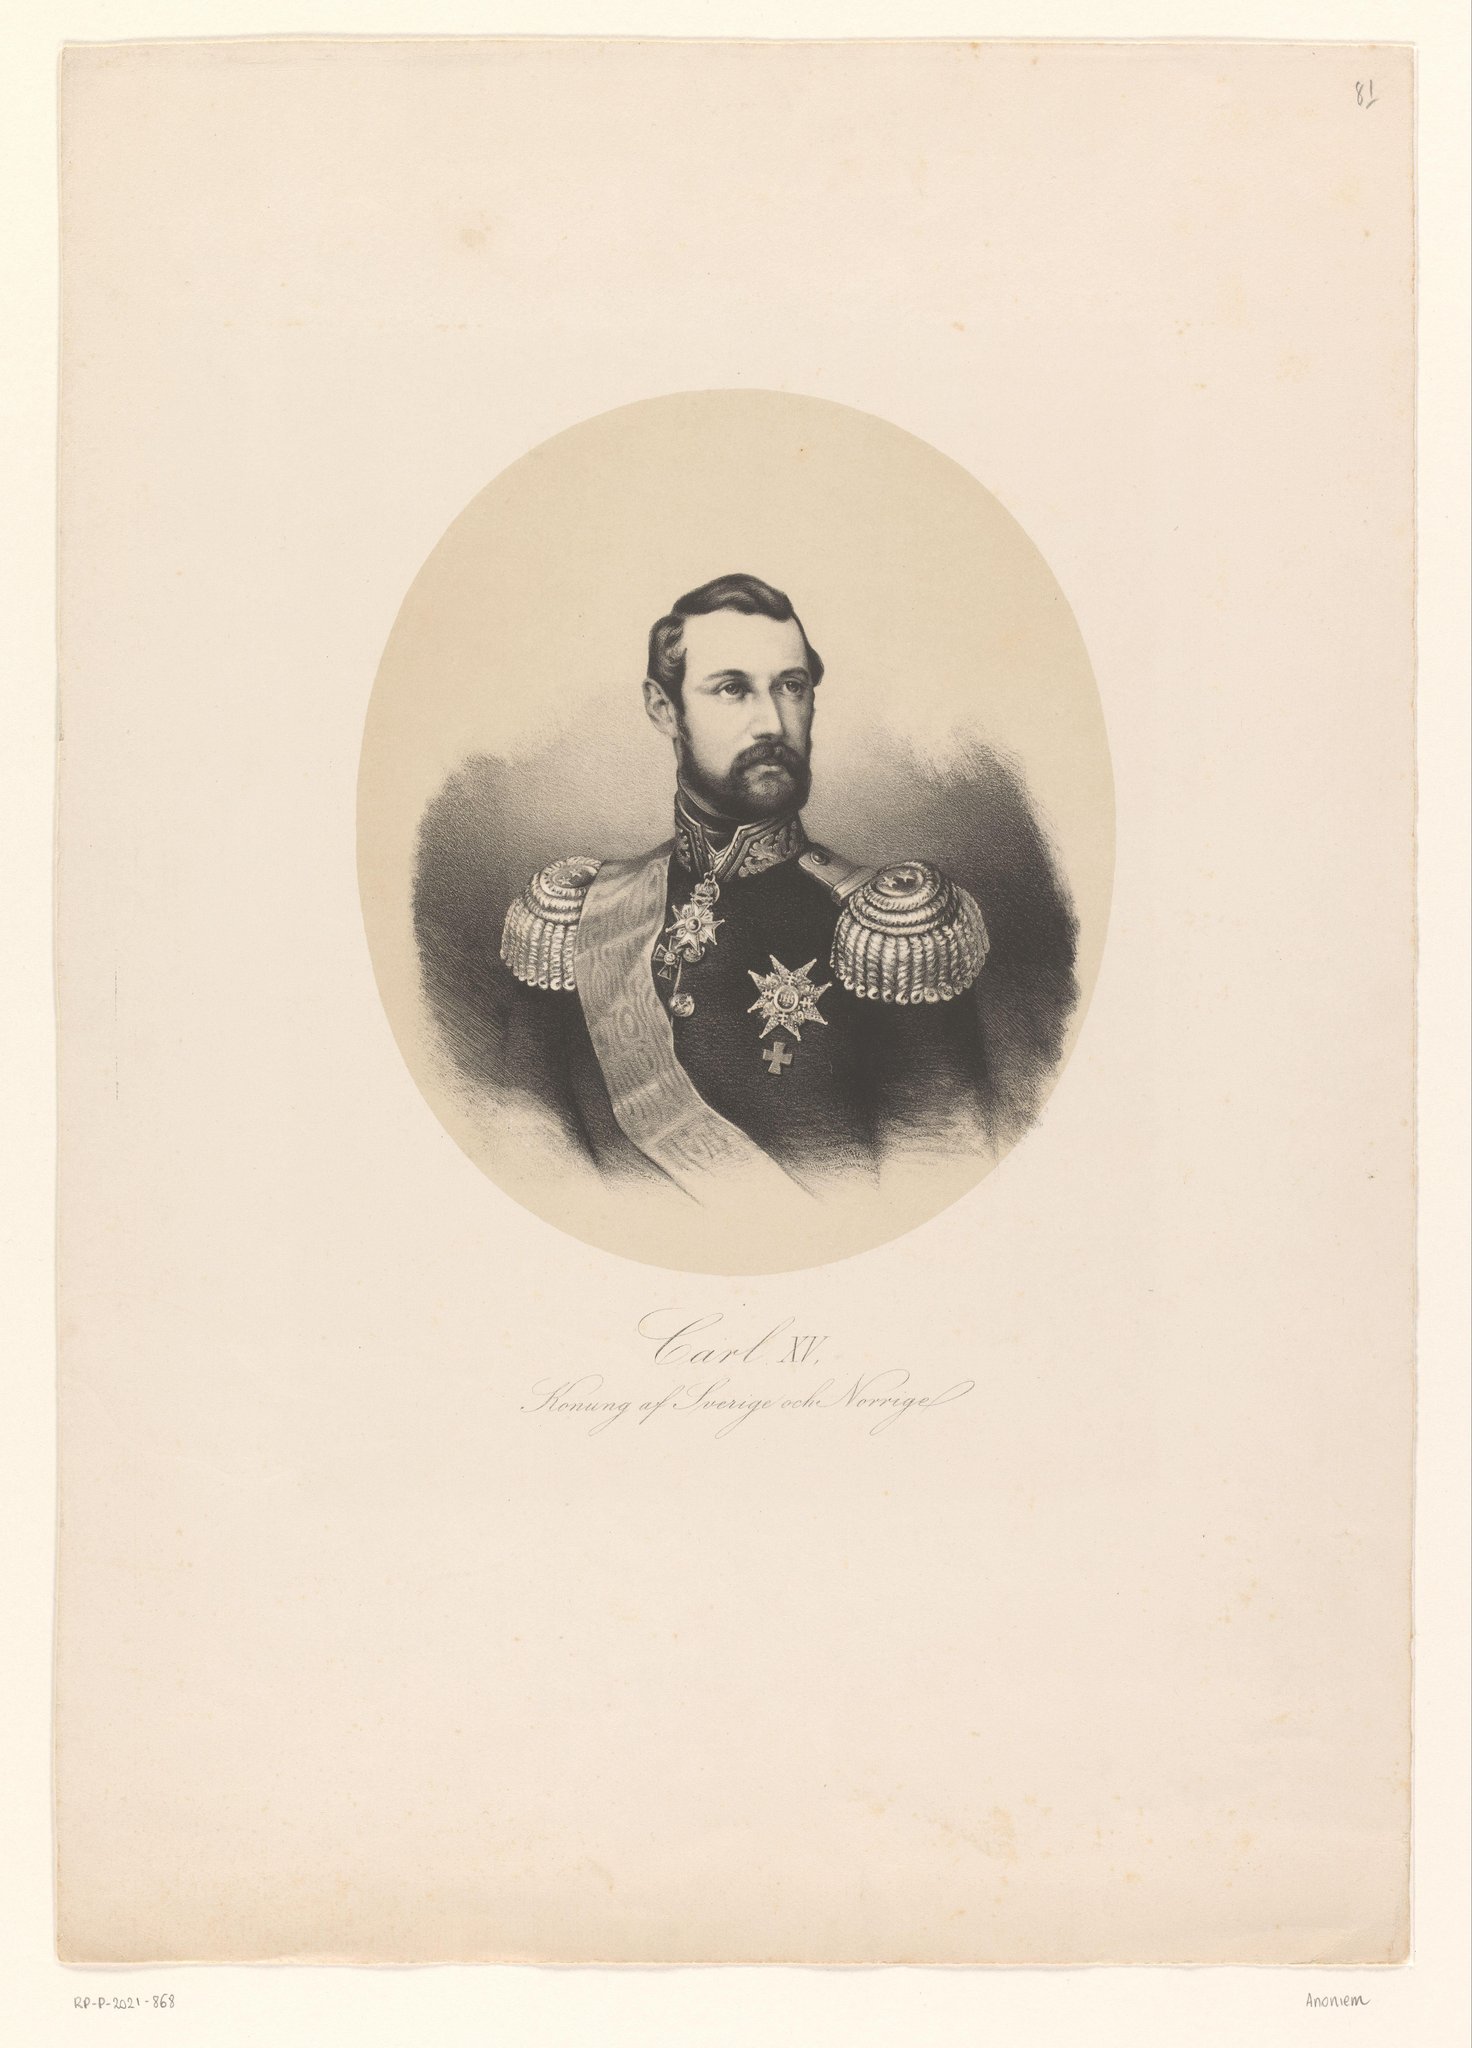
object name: print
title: Portret van Karel XV van Zweden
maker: Anonymous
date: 1859-1899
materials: paper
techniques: tone lithography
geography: sweden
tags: karel xv (koning van zweden en noorwegen), historical persons, (military) uniforms, king